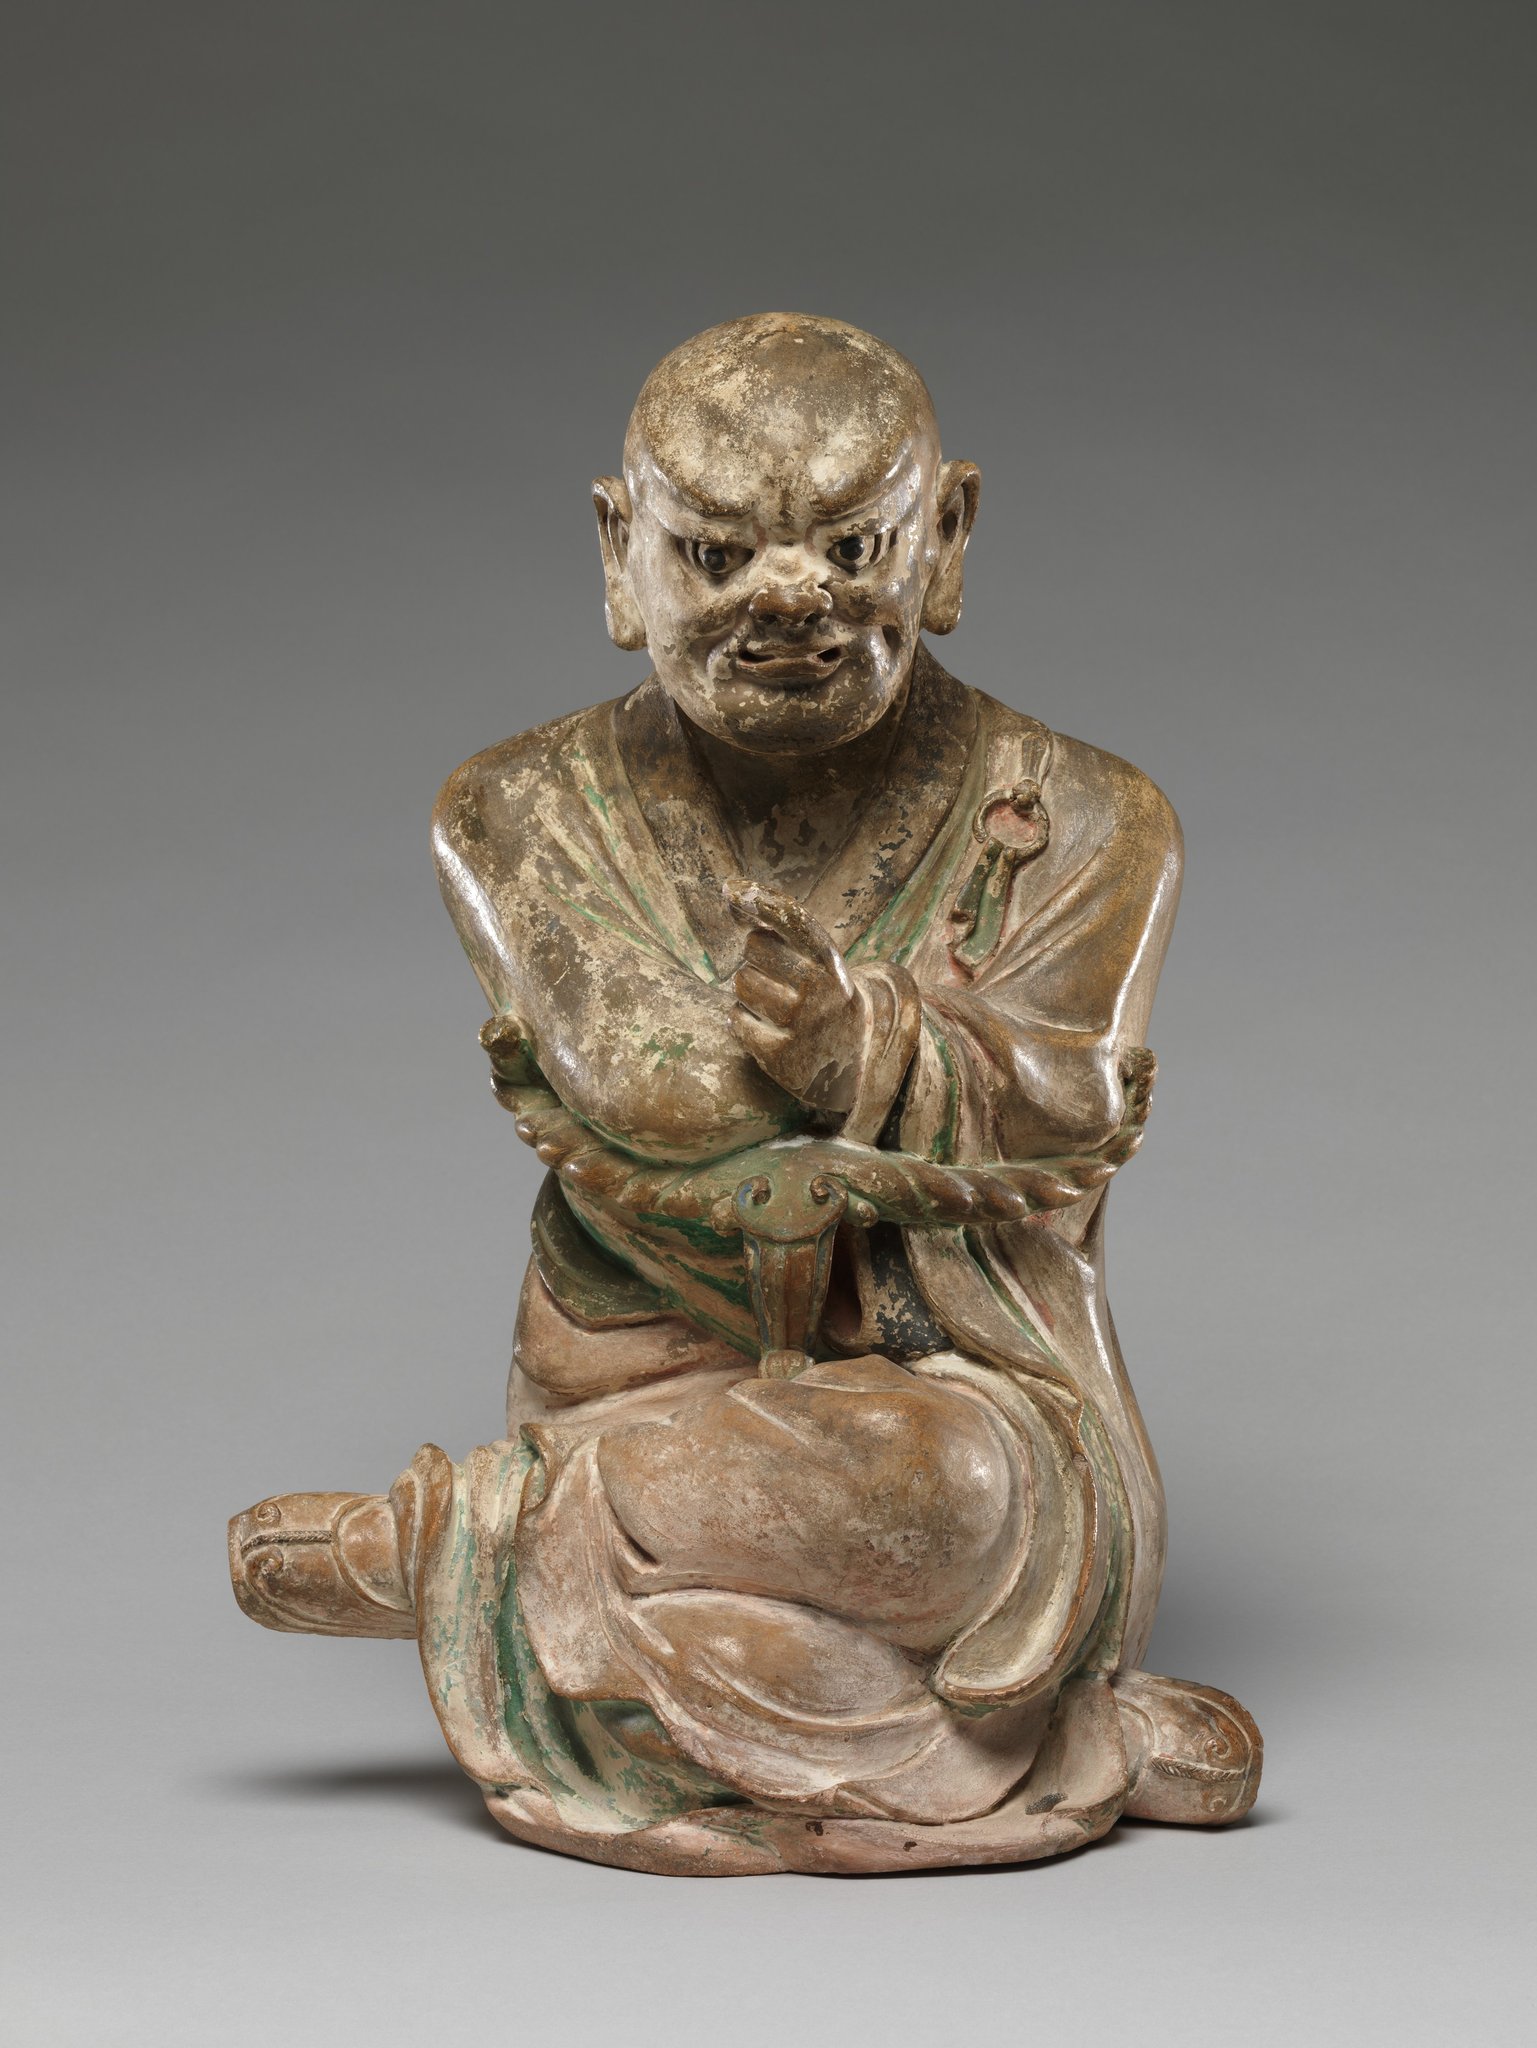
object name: figure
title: Luohan with an armrest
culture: chinese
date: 1801-2000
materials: pigment, stoneware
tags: men,buddhism